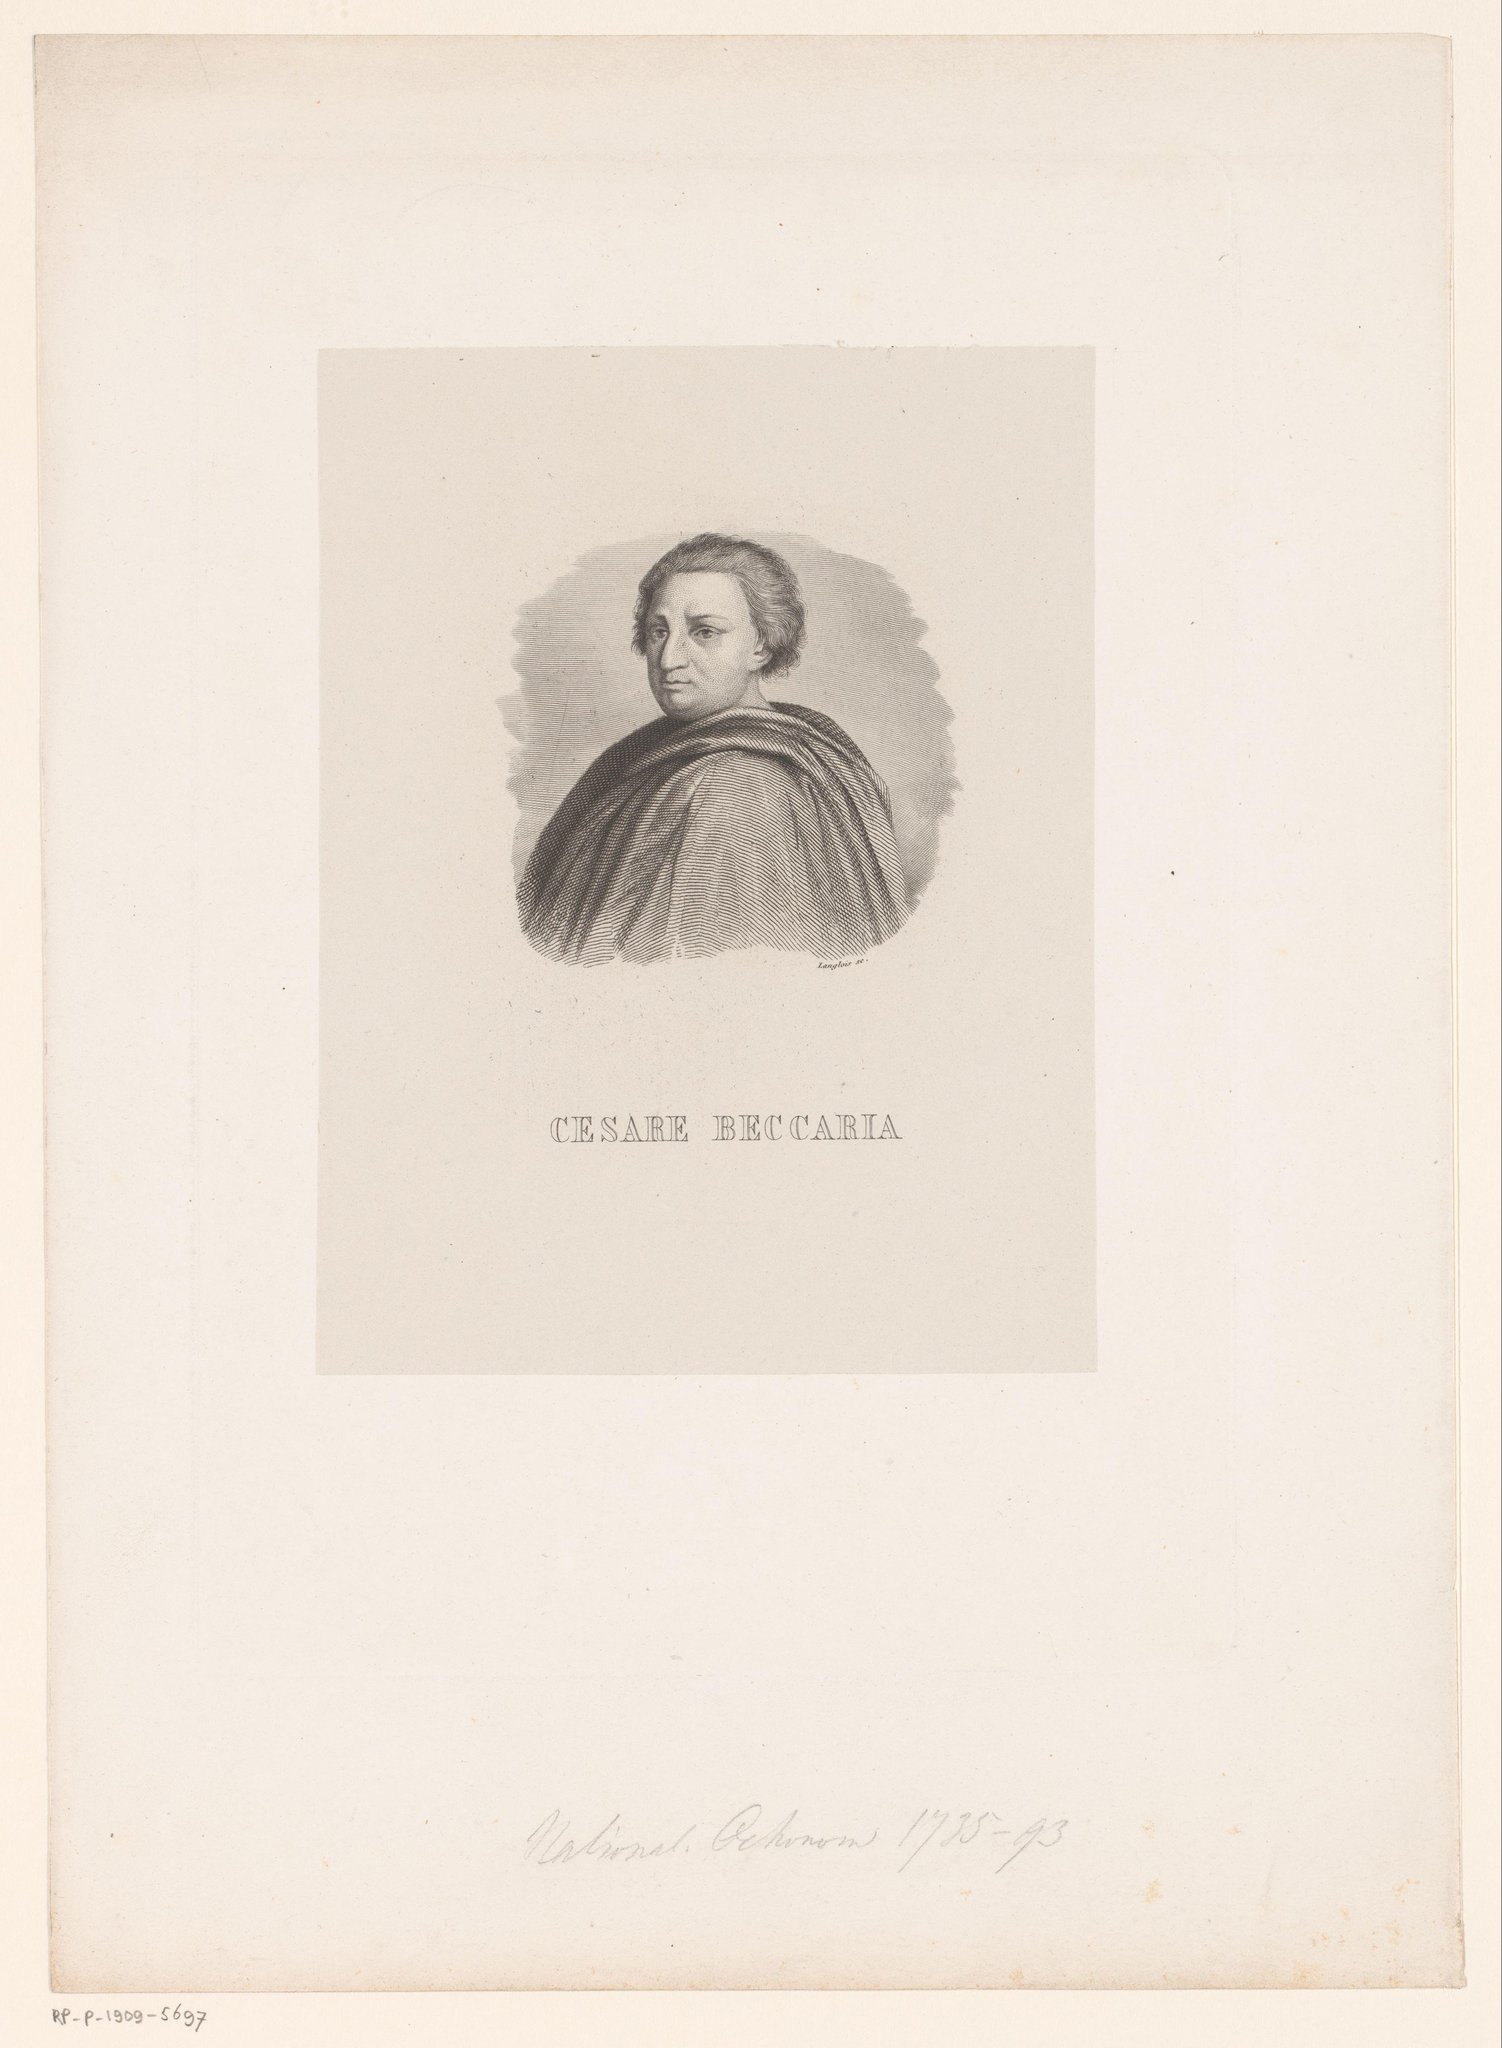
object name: print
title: Portret van Cesare Beccaria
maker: pierre gabriel langlois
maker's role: print maker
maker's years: 1754-1810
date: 1764-1810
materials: paper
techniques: etching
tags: politician, scholar, philosopher, historical persons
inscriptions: collector's mark: Lugt 2228